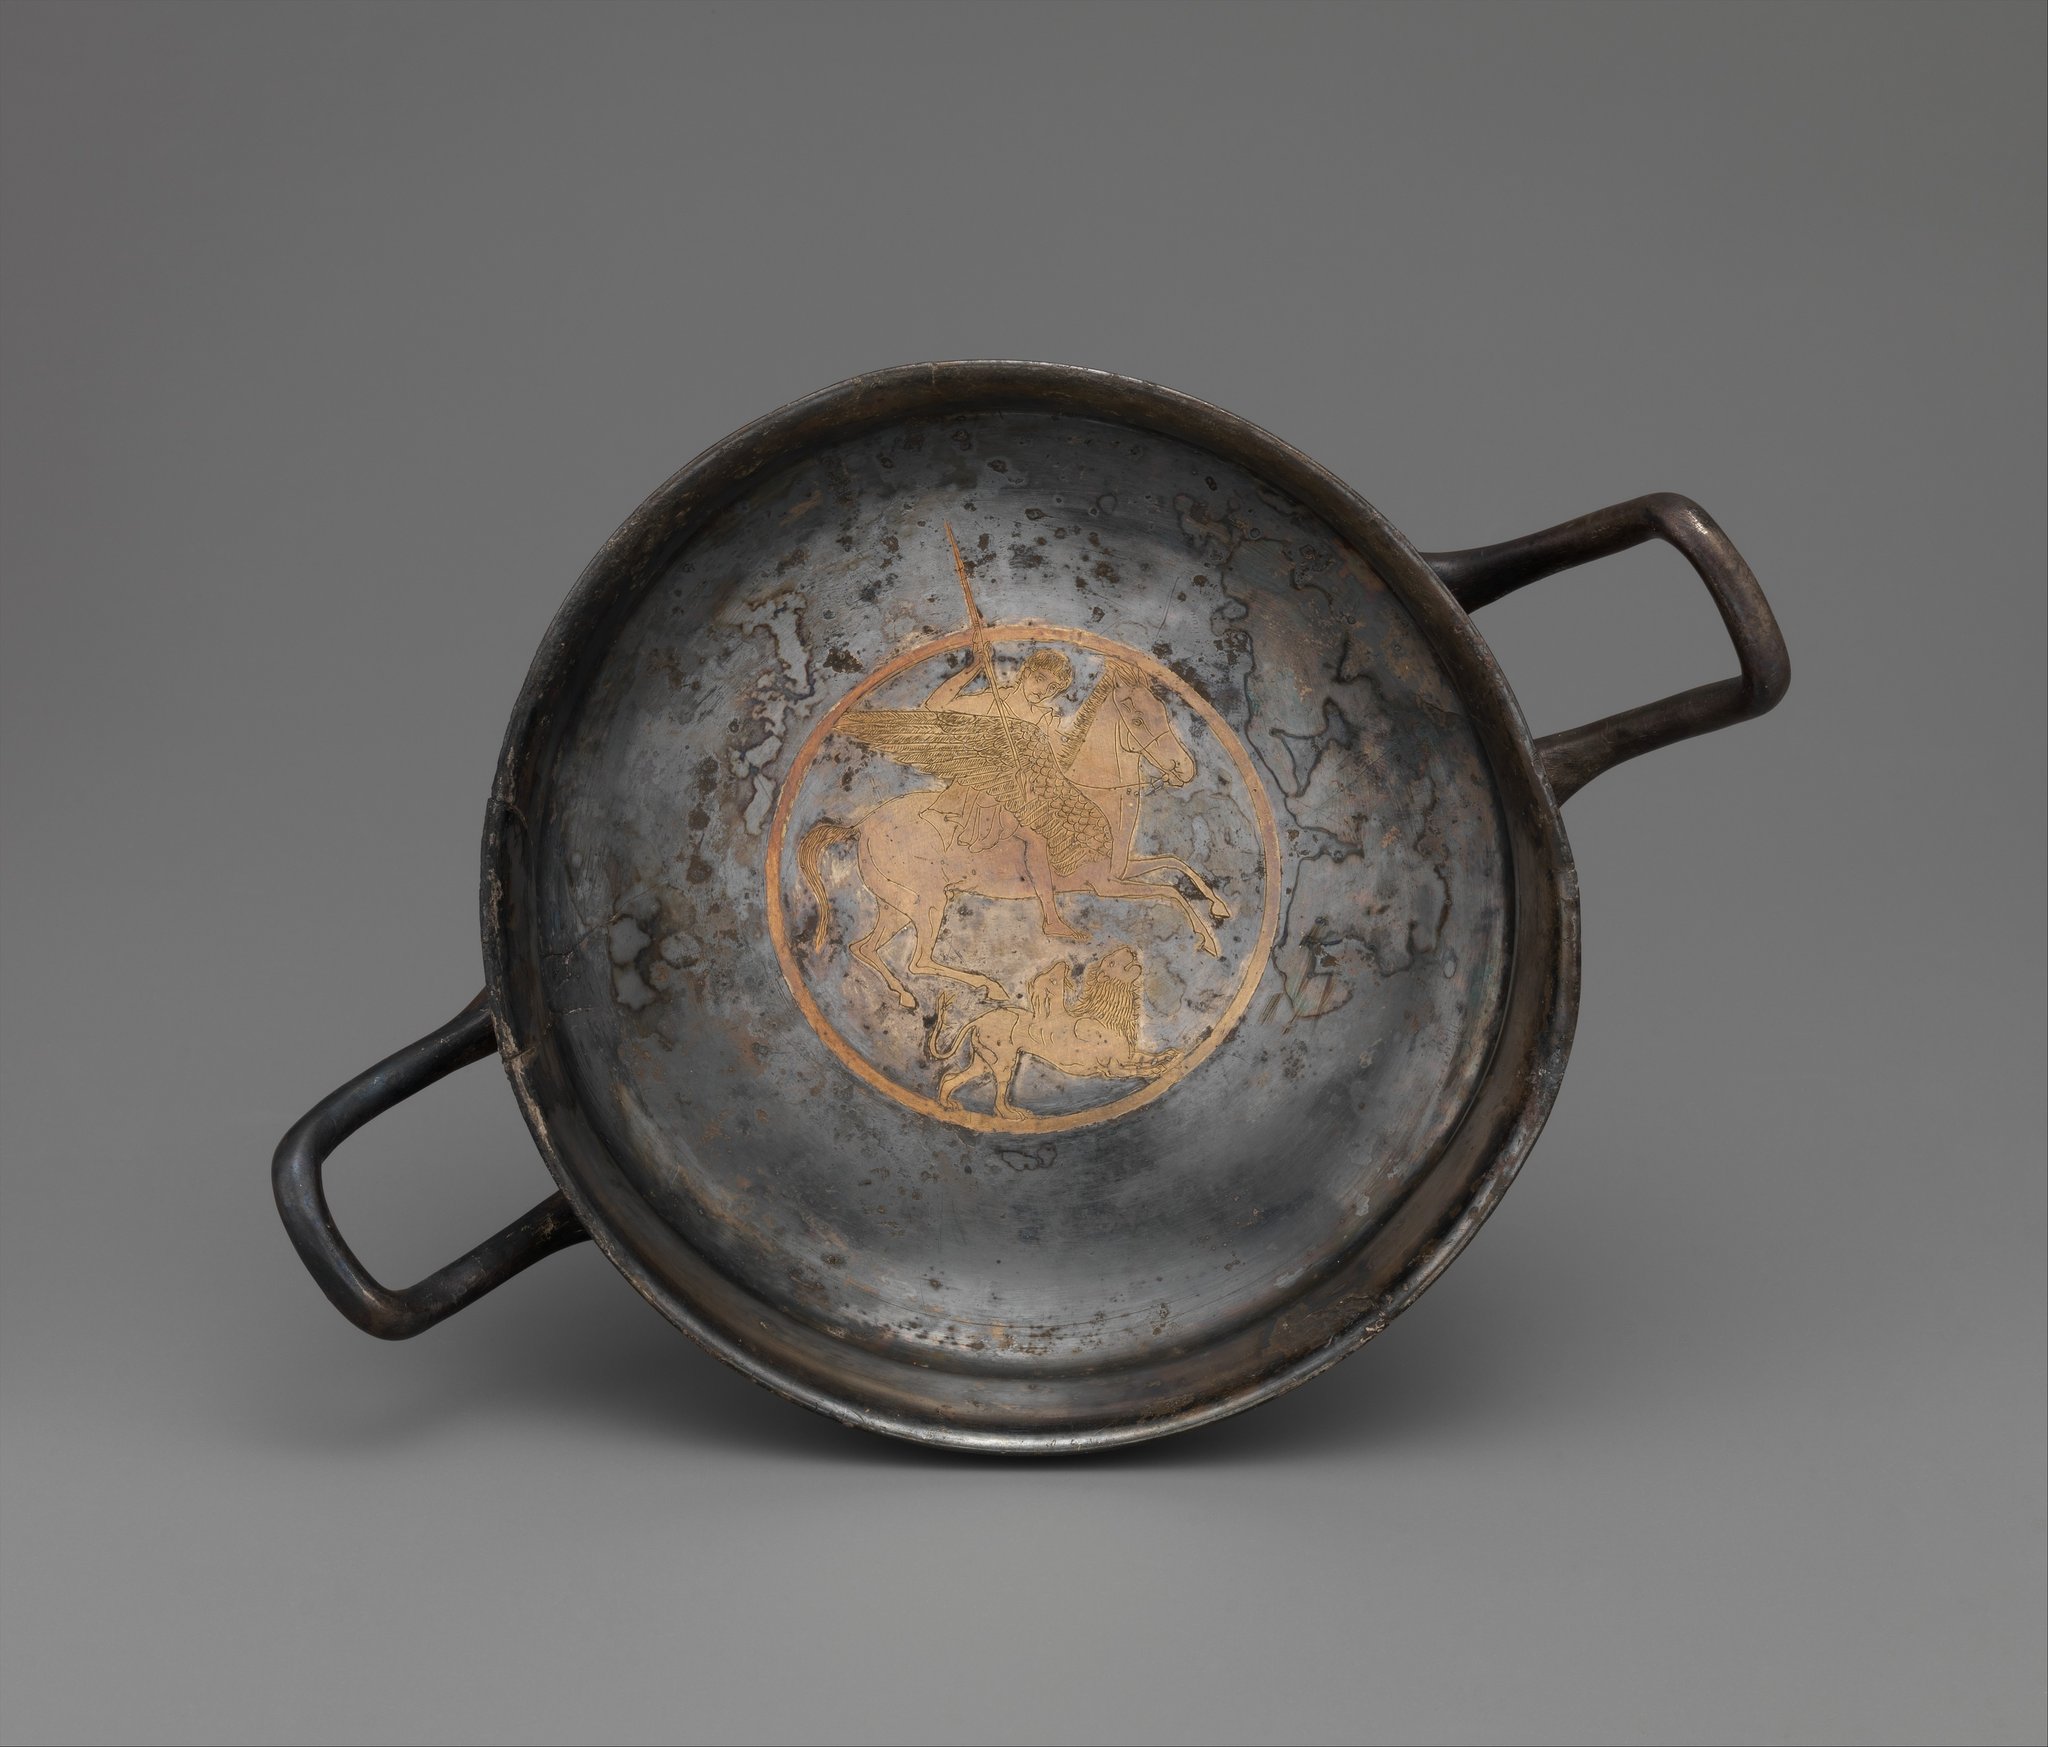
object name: kylix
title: Gilt silver kylix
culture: greek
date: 434-401 BCE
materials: silver gilt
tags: mythical creatures,pegasus